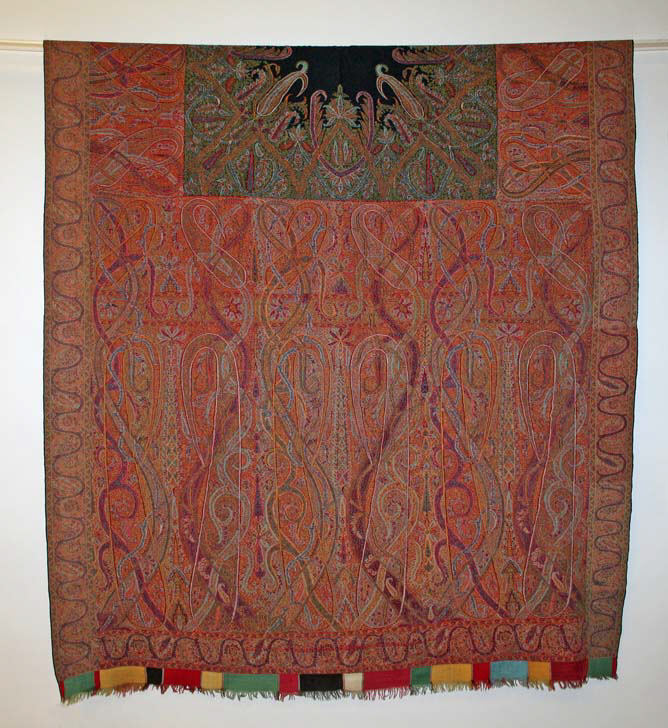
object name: shawl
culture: scottish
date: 1870-1879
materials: wool